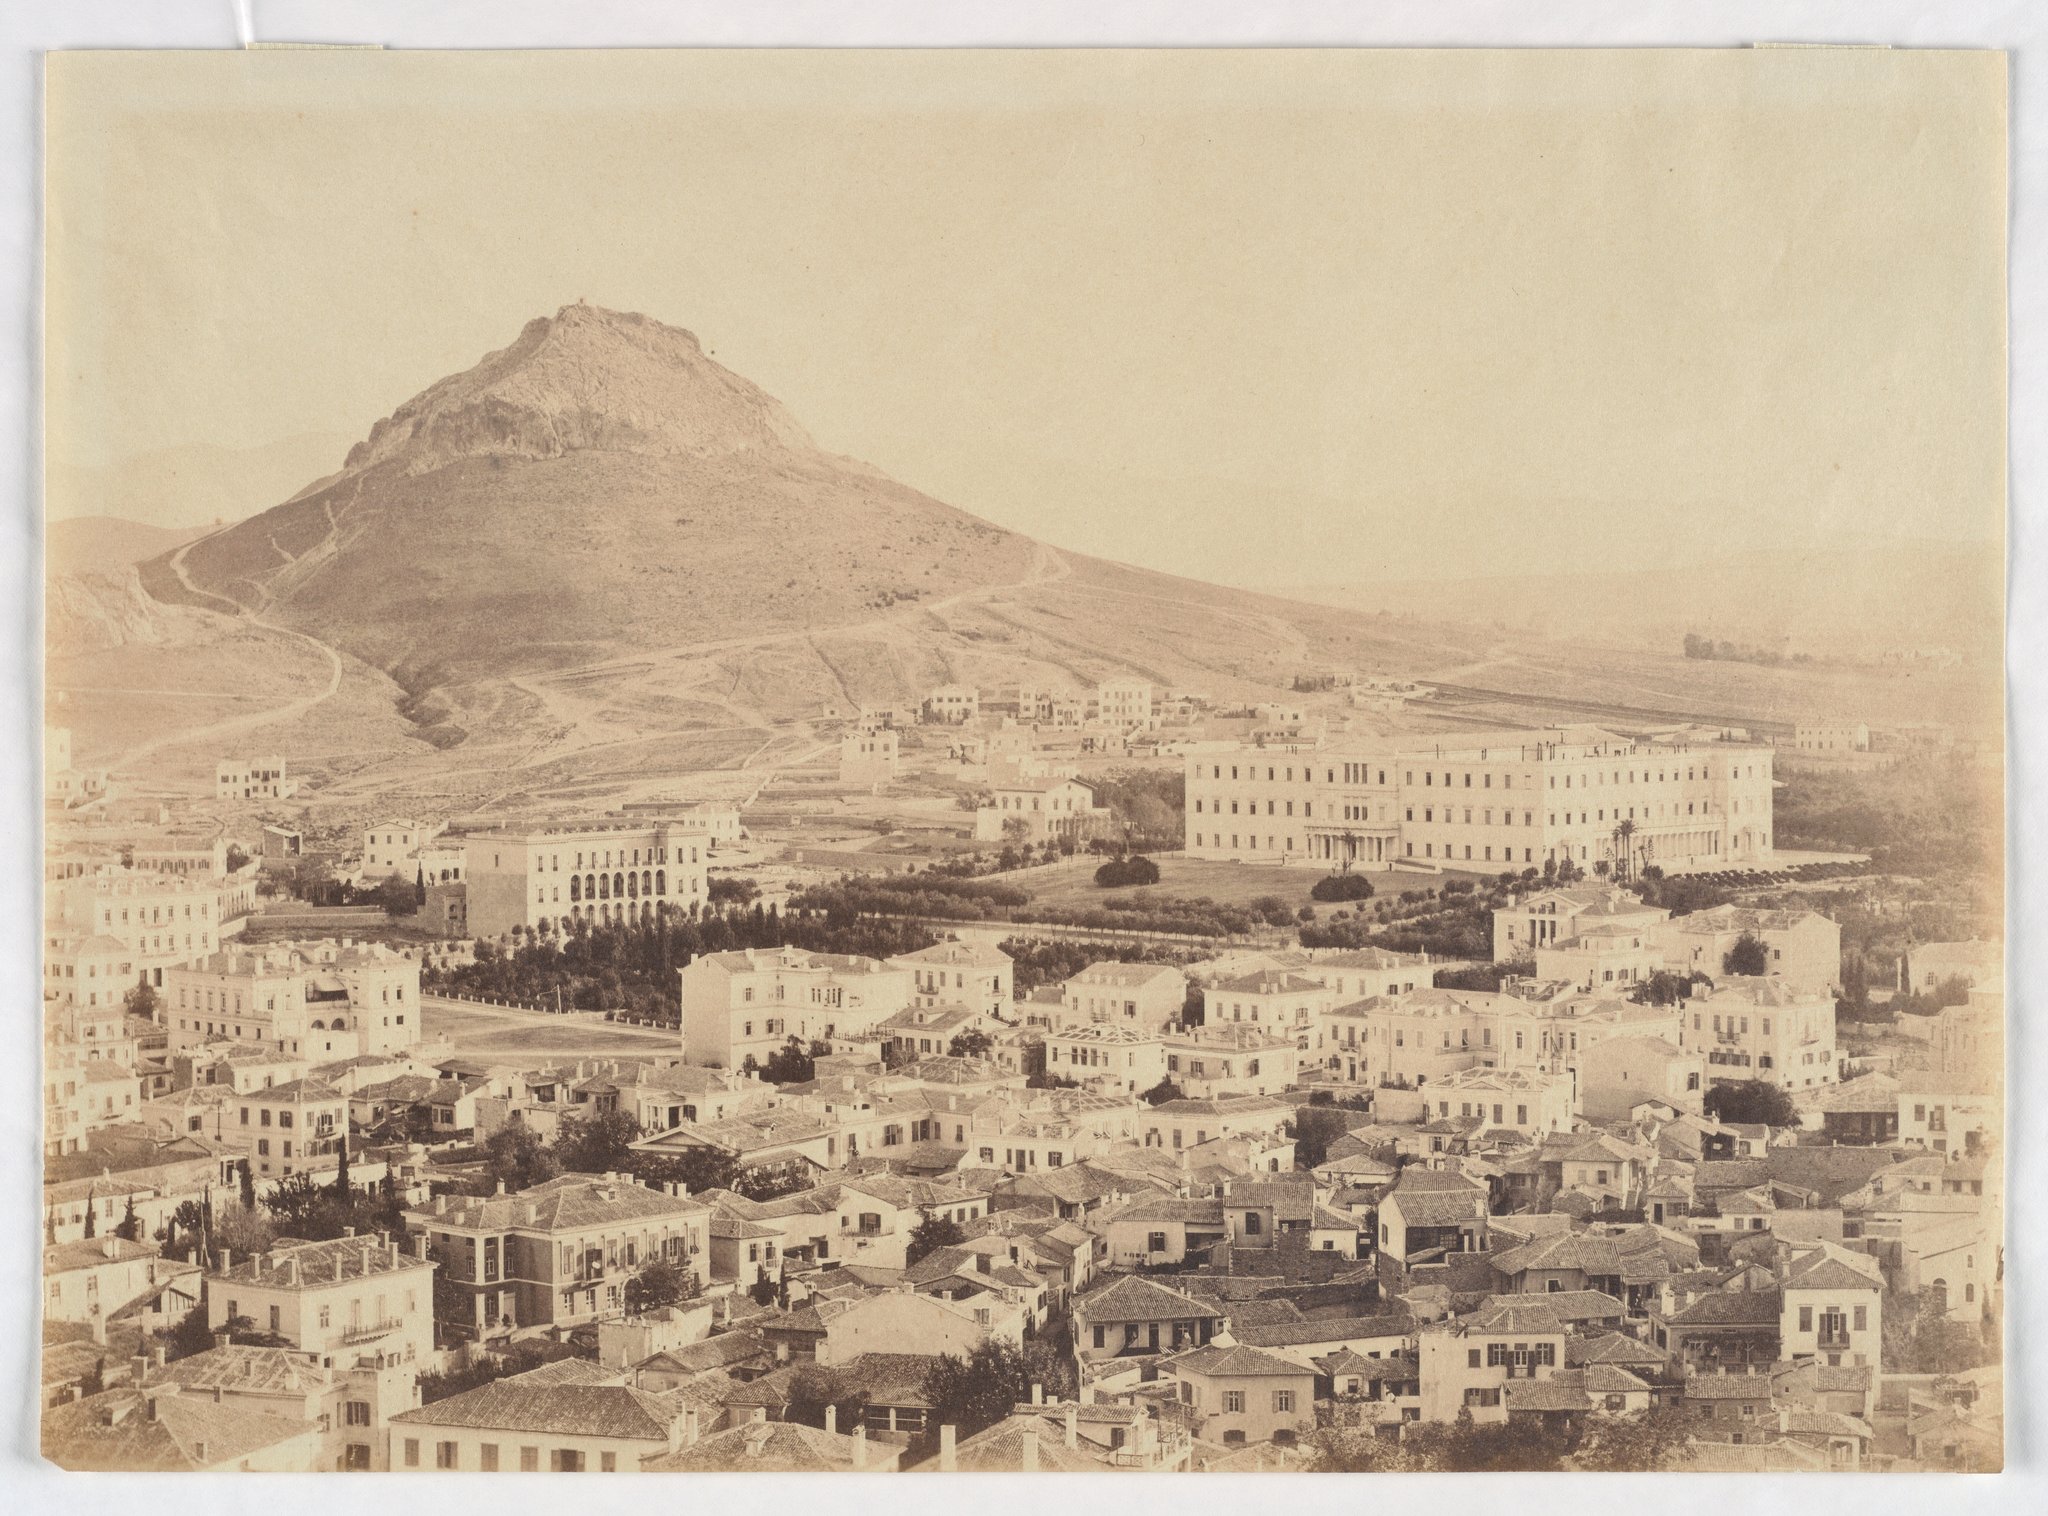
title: [Acropolis, Athens, Greece]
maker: james robertson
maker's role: artist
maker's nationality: british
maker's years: 1813-1881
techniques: salted paper print